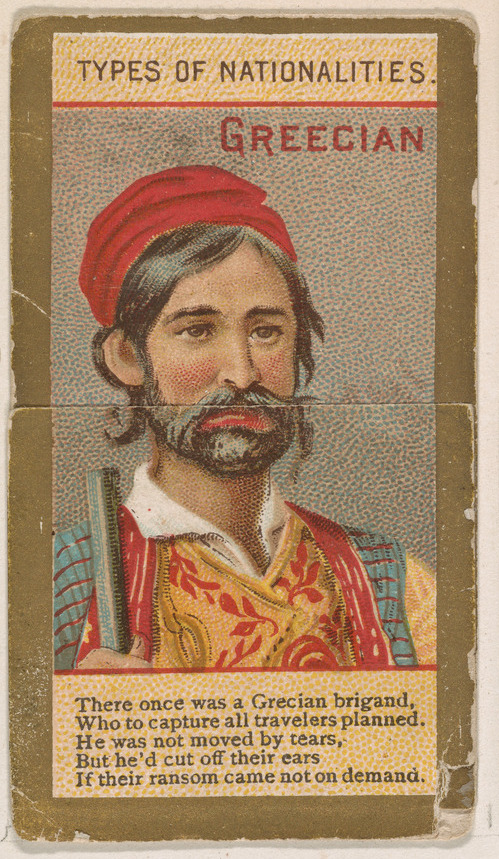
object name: print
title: Greecian, from Types of Nationalities (N240) issued by Kinney Bros.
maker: kinney brothers tobacco company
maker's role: publisher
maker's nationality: american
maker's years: 1869-2011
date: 1890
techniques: color lithograph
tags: men